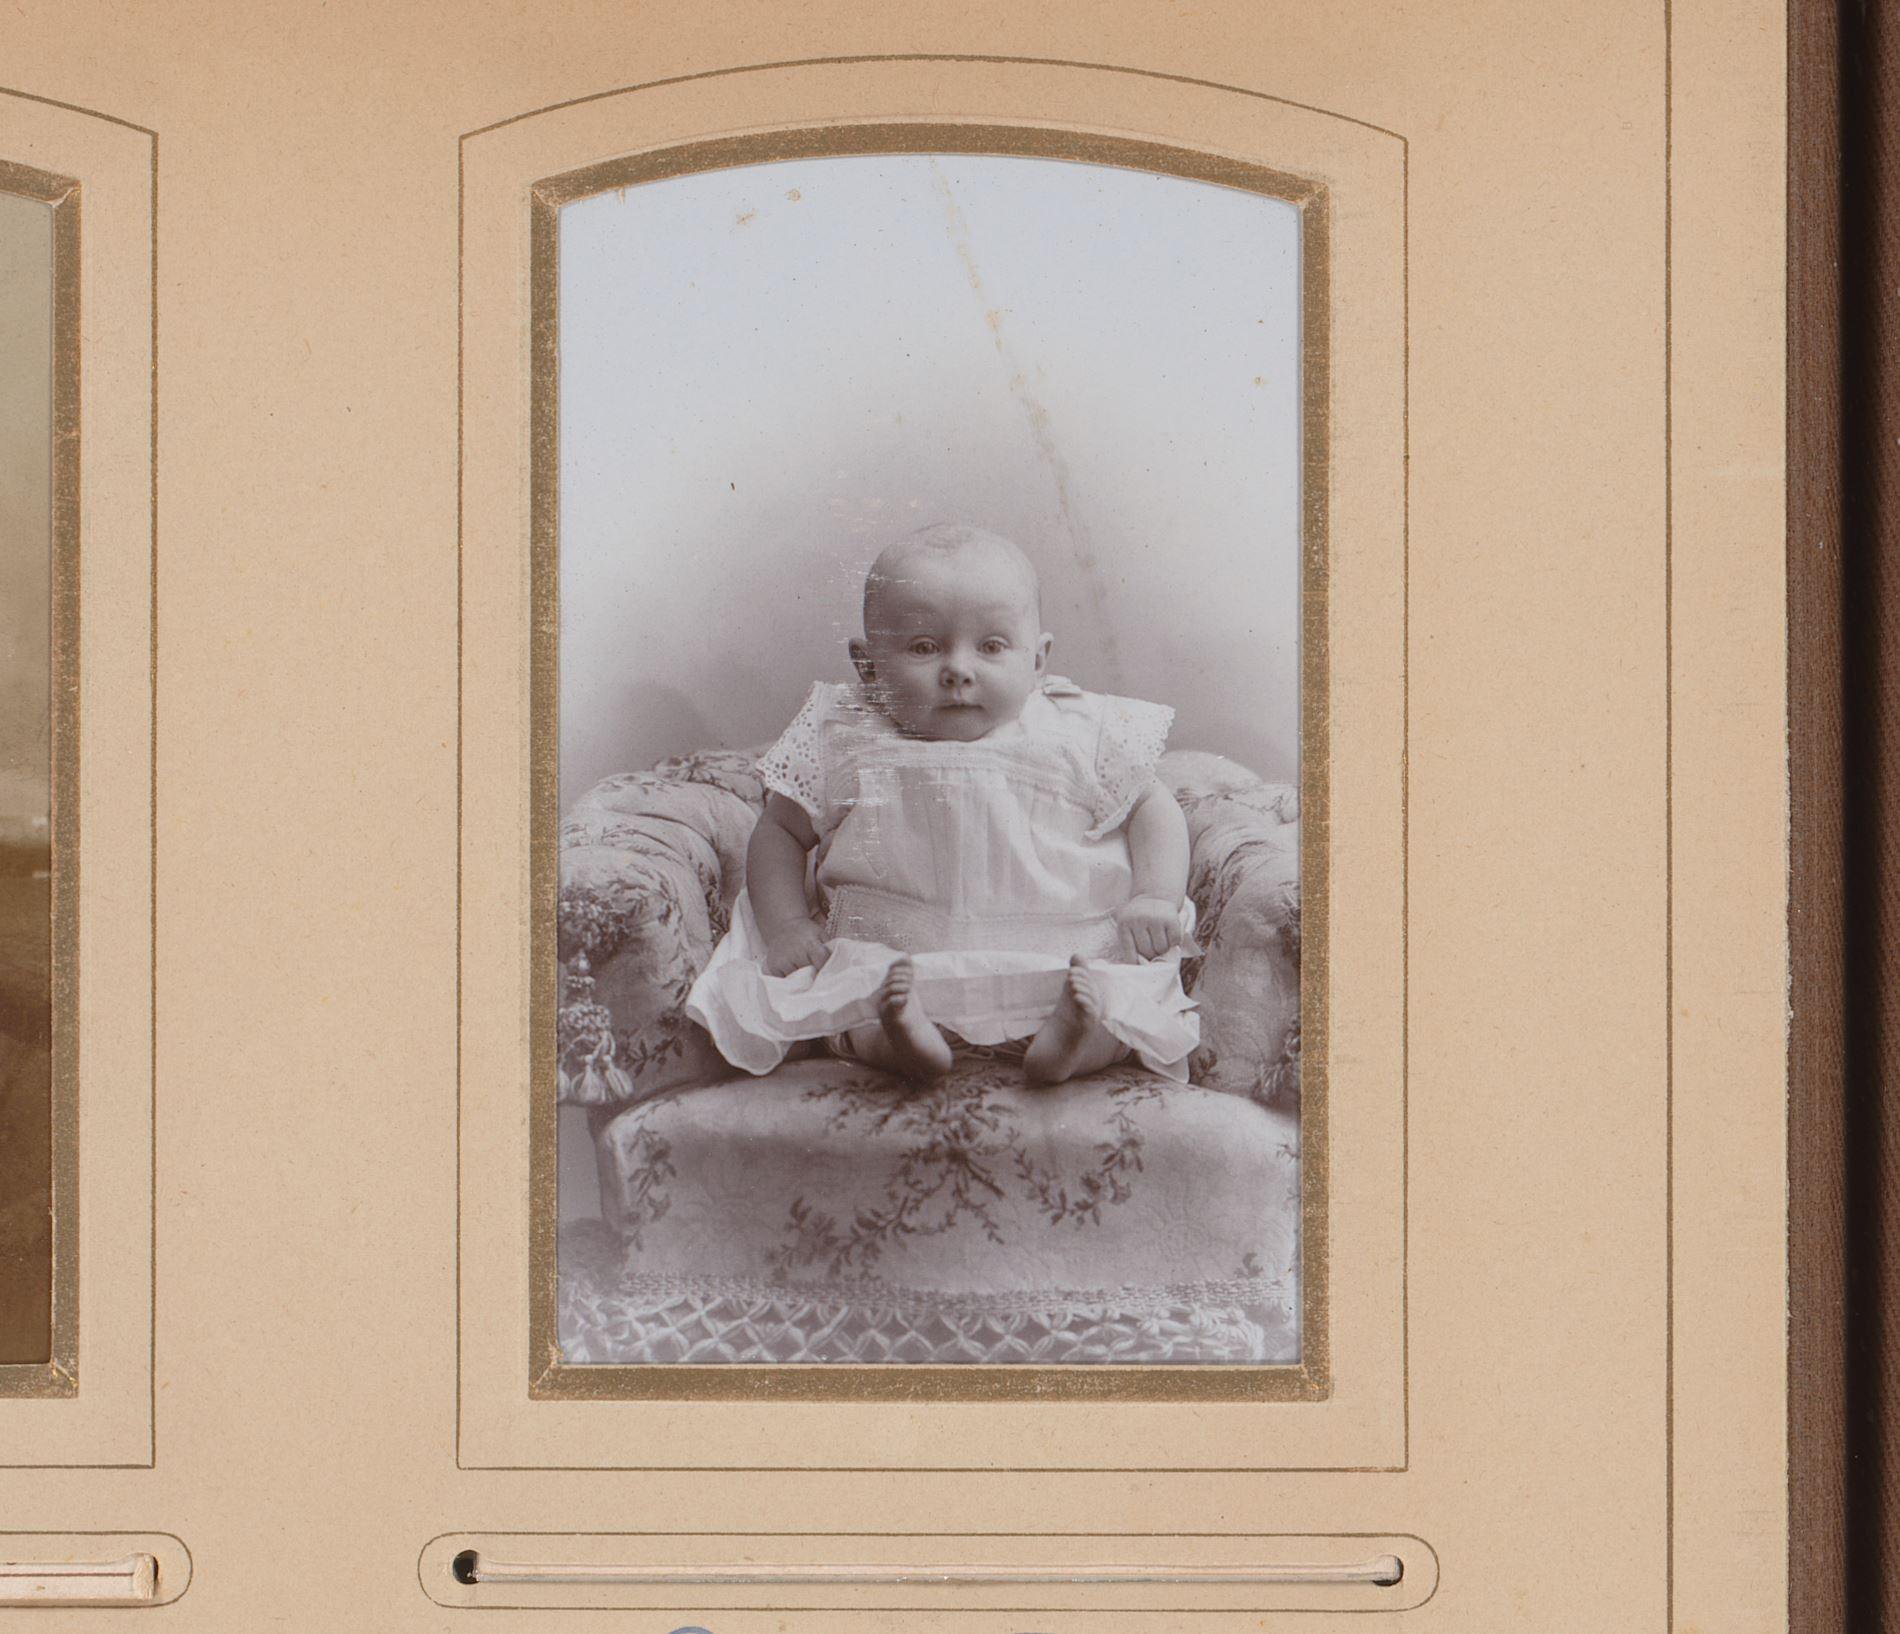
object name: carte de visite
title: Portret van een zittende baby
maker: Anonymous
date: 1880-1920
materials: cardboard, photographic support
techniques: collodion silver print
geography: netherlands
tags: sitting figure, historical persons, infant, baby ~ the ages of man